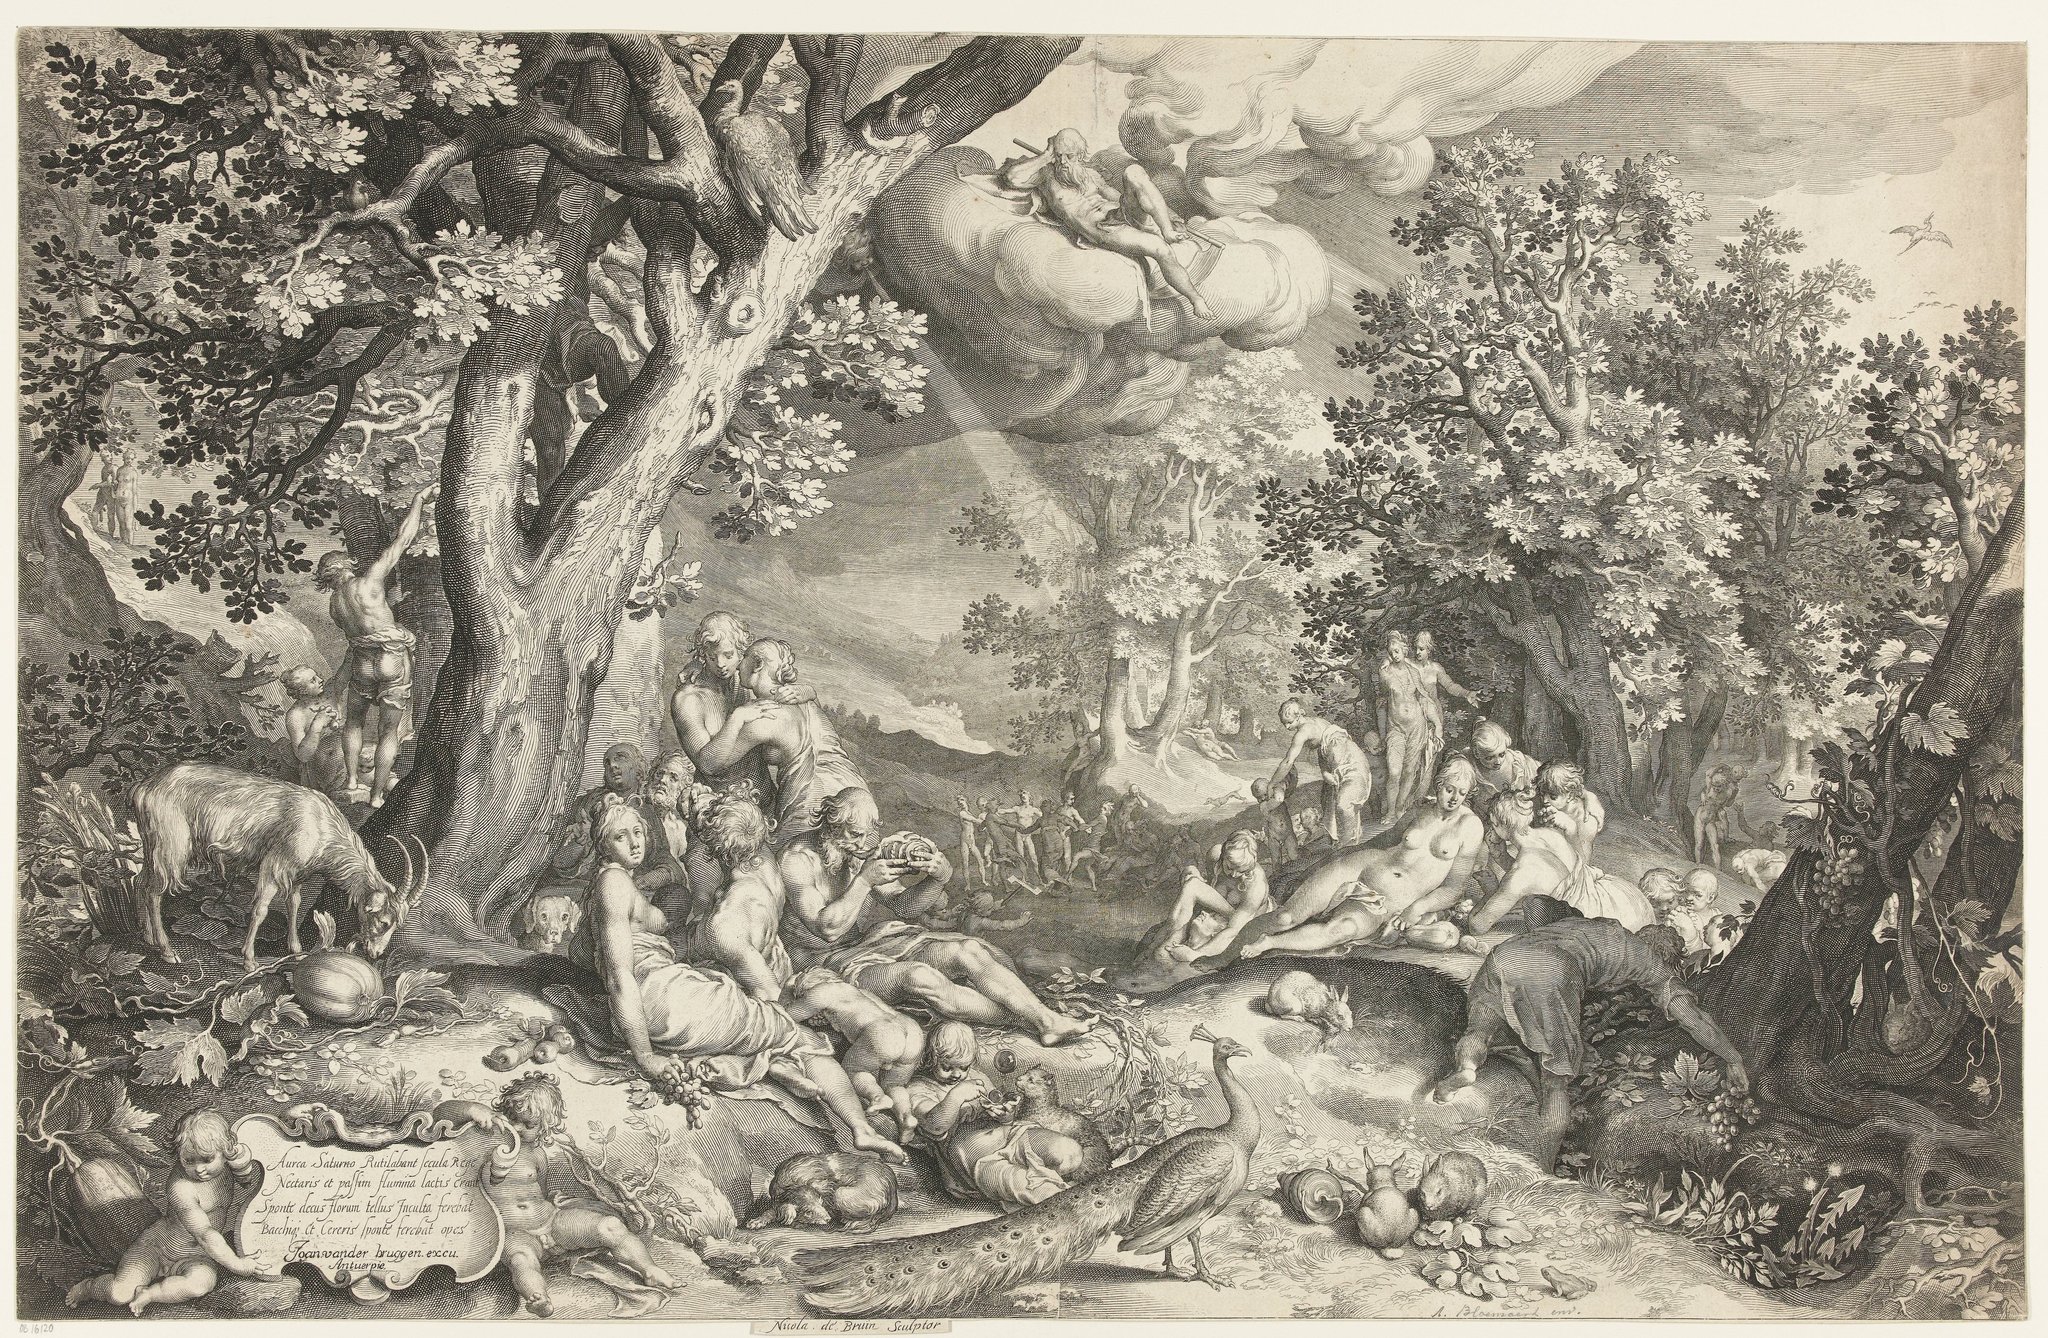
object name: print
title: Gouden Eeuw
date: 1604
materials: paper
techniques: engraving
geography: antwerp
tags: the golden age, 'aetas aurea'; men live happily, gathering fruits under the reign of saturn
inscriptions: collector's mark: Lugt 2228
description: In een paradijselijk landschap genieten naakte mensen van het fruit dat de vrijgevige natuur hen schenkt. Ze dansen en zitten te minnekozen. Een jongetje op de voorgrond blaast zeepbellen uit een pijp. Links op de voorgrond houden twee putti een cartouche met een Latijnse tekst vast. In de lucht waakt de god Saturnus over deze Gouden Eeuw. De prent refereert aan het mythologisch geïnspireerde idee dat de mens aanvankelijk leefde in een tijdperk van voortdurende lente. Oorlog of onrechtvaardigheid waren afwezig. Tijdens de Gouden Eeuw leefde iedereen in gelukzaligheid, in een wereld waar men zonder te werken kon genieten van de vruchtbare natuur.